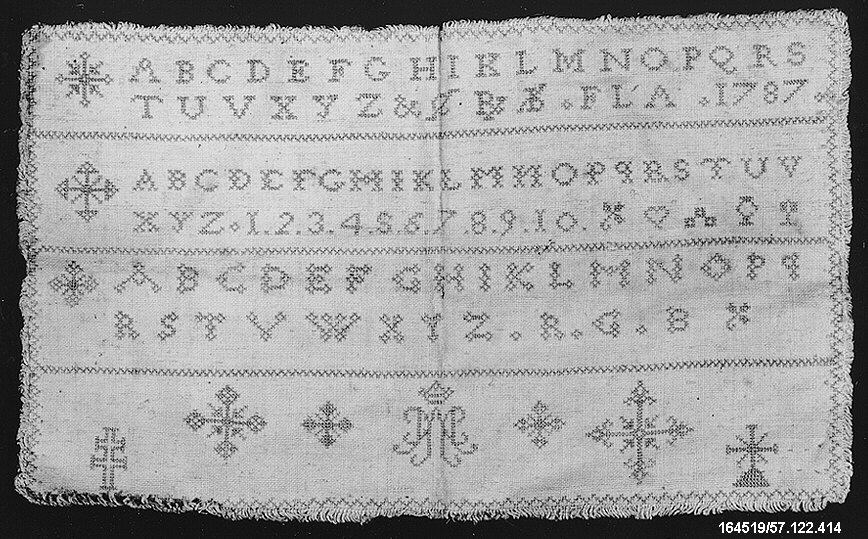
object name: sampler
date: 1787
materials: linen, silk